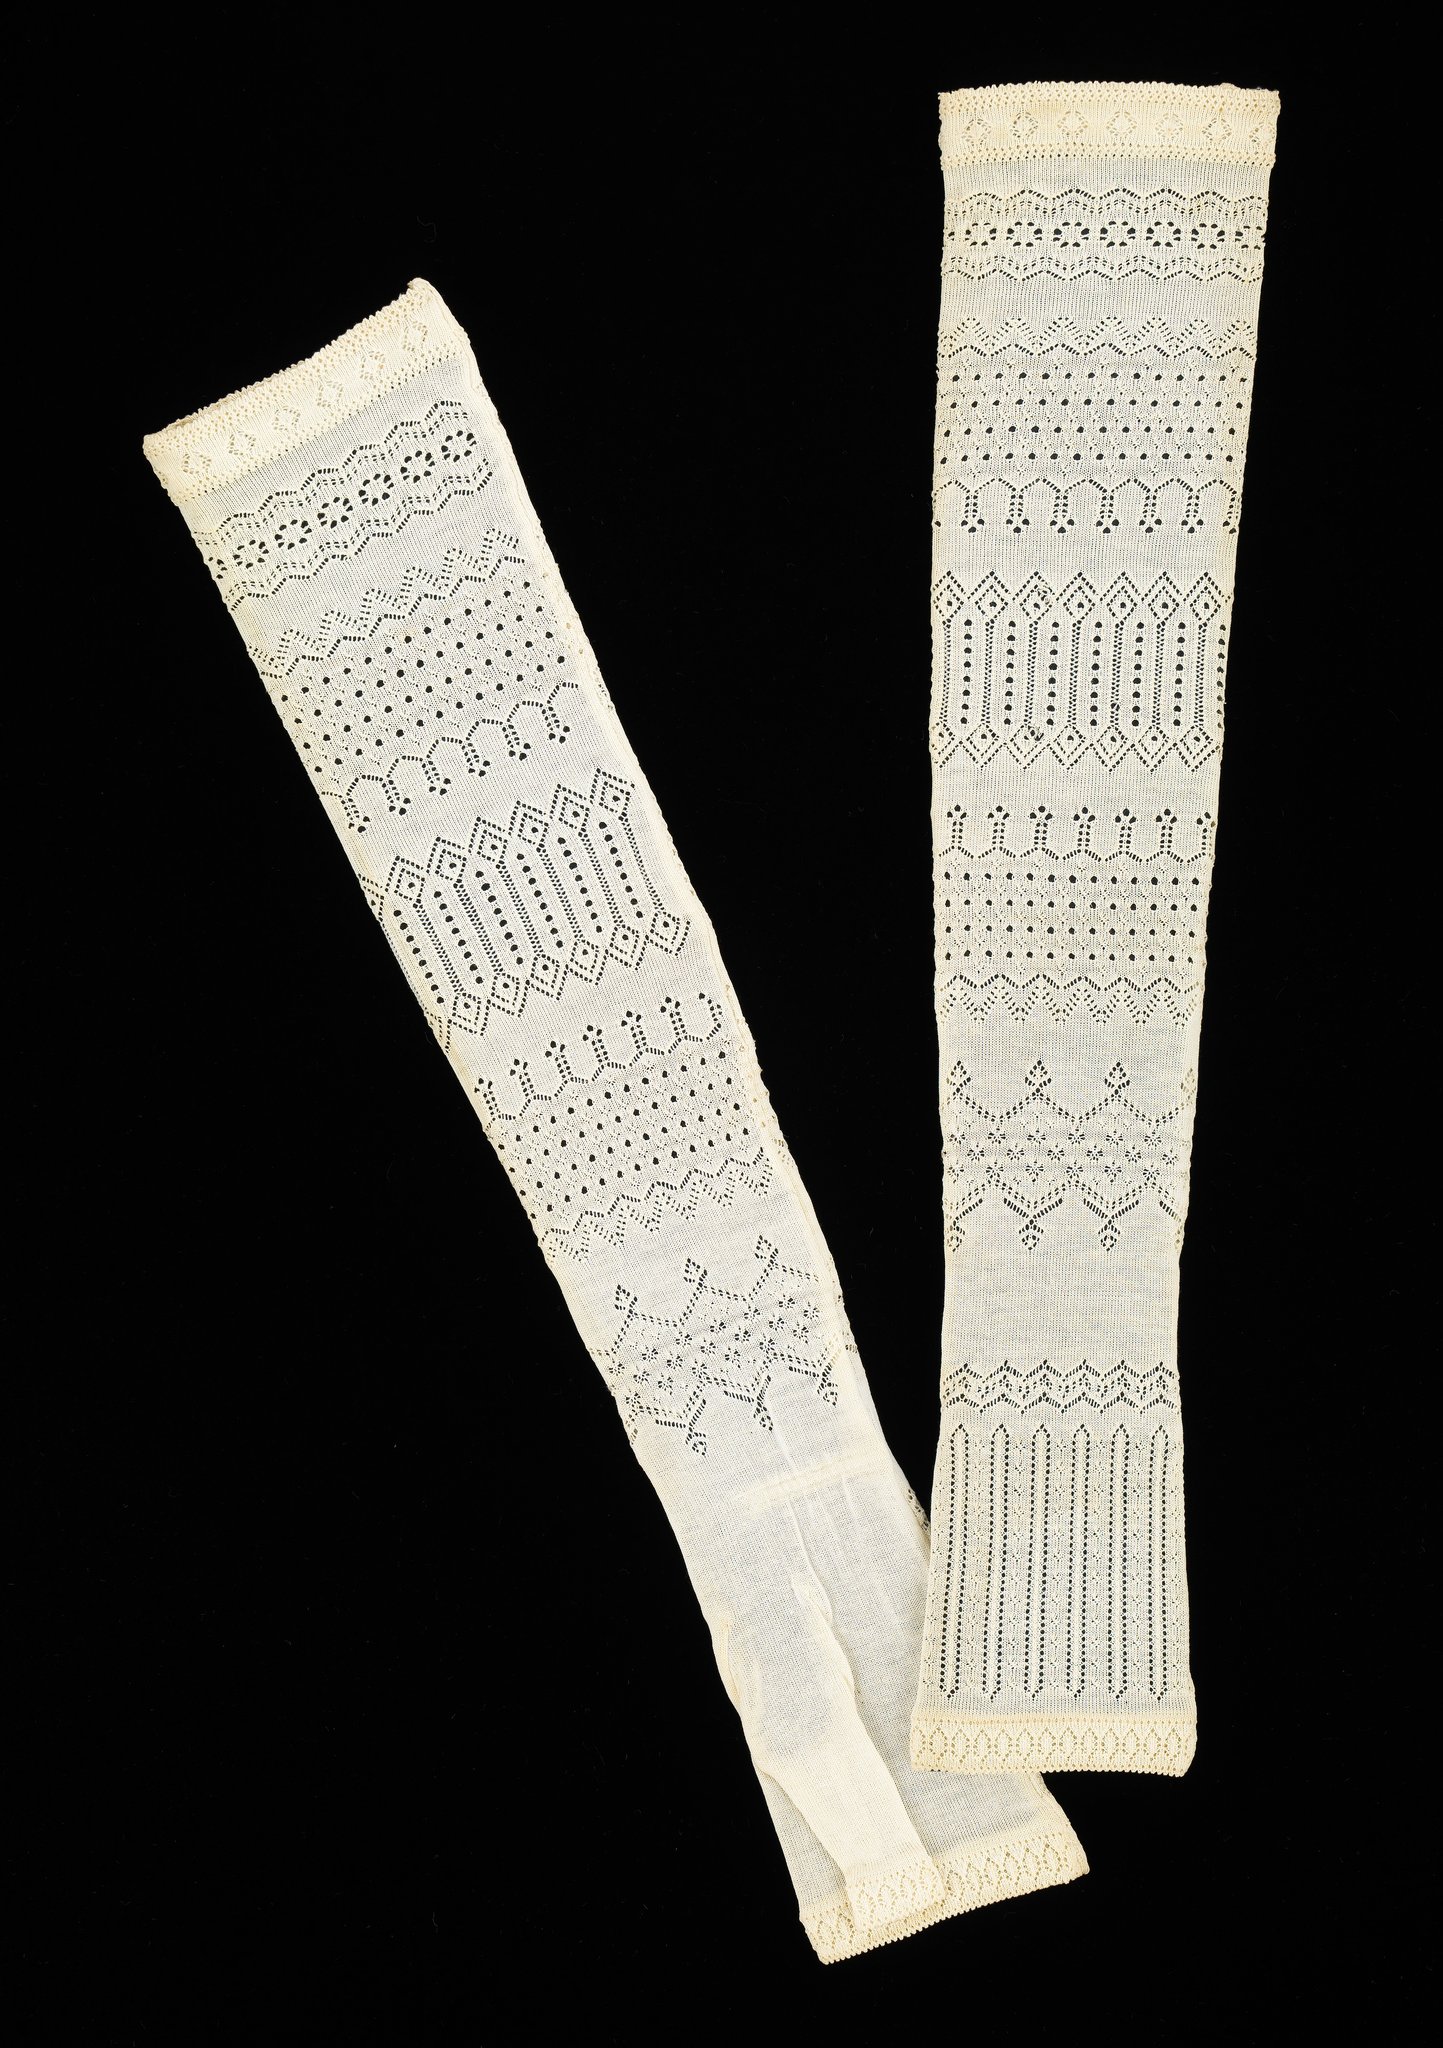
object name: evening mitt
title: Evening mitts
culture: german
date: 1876-1900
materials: cotton